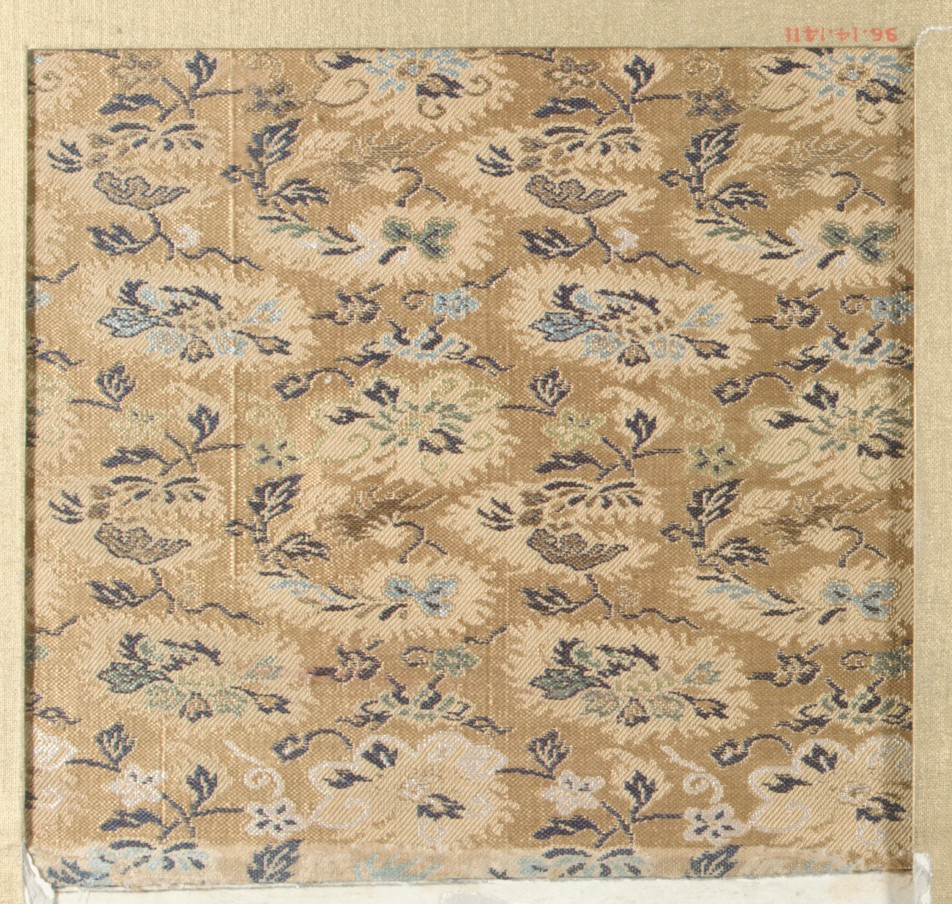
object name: piece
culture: japanese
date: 1701-1900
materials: silk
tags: flowers